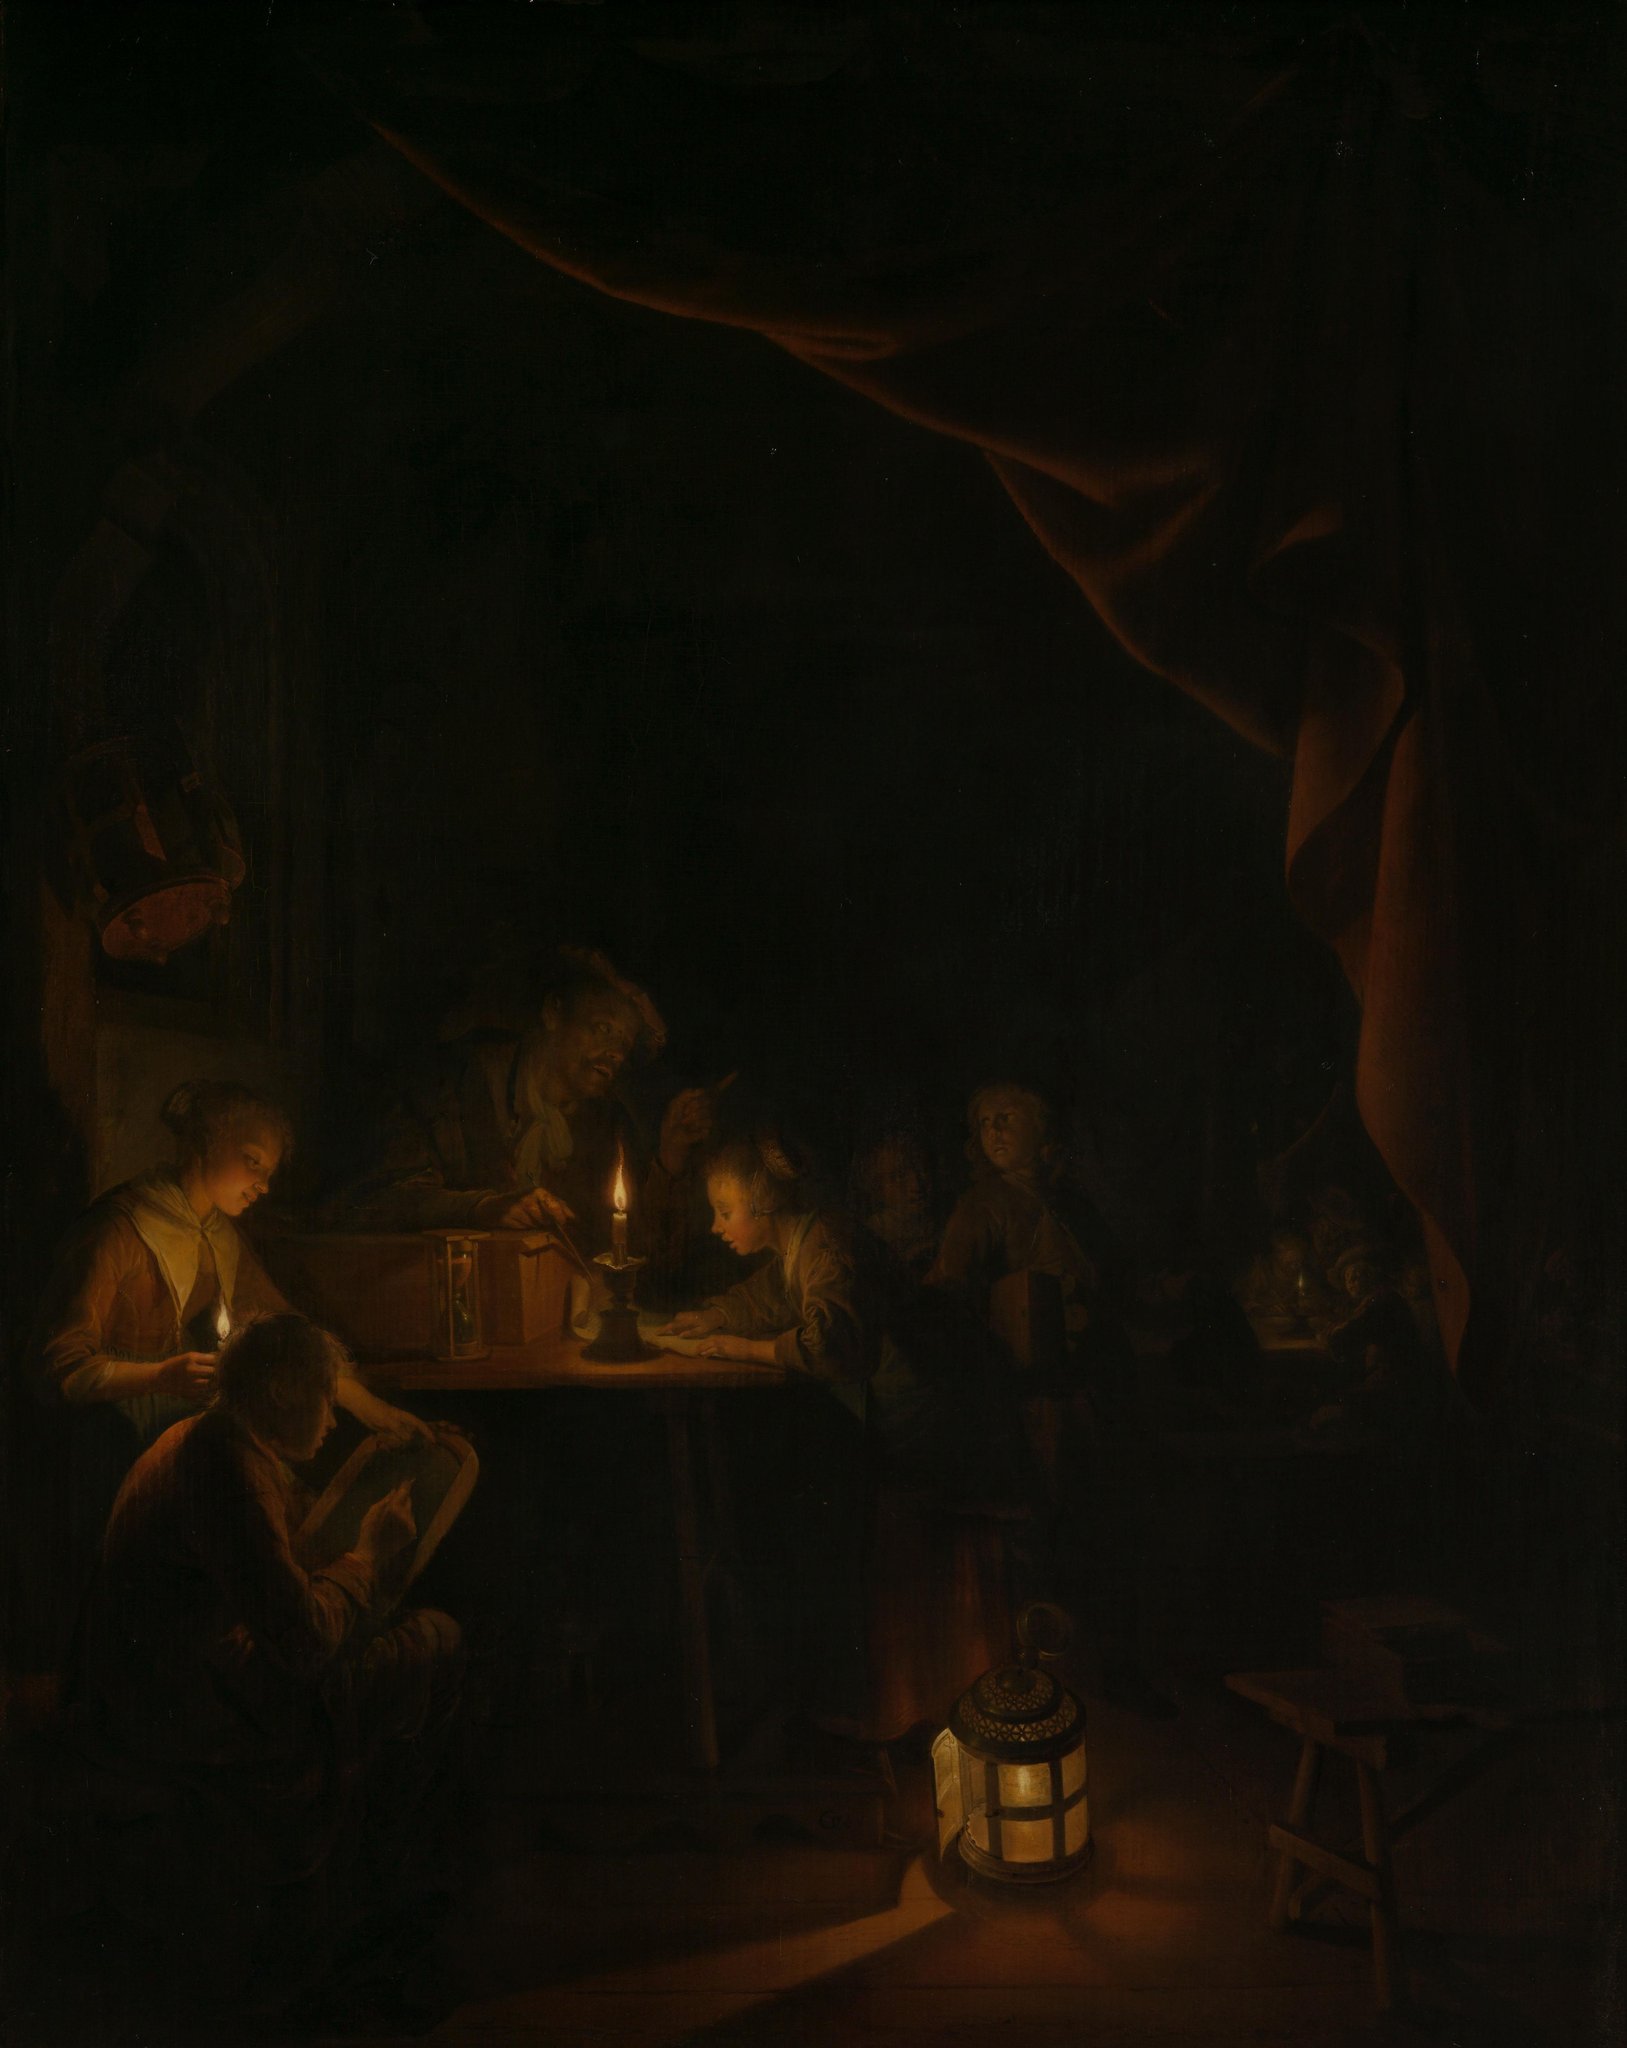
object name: painting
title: The Night School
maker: gerard dou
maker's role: draughtsman, painter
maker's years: 1613-1675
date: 1660-1665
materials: oil, panel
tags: candle, elementary school; class, form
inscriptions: signature: ‘GDou’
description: Light and dark, virtue and vice are juxtaposed here. Bathed in bright candlelight, a girl earnestly recites her lesson, while in the shadows the schoolmaster admonishes a boy. In the foreground, a second pupil, candle in hand, helps another with his schoolwork. The candlelight here symbolizes reason.